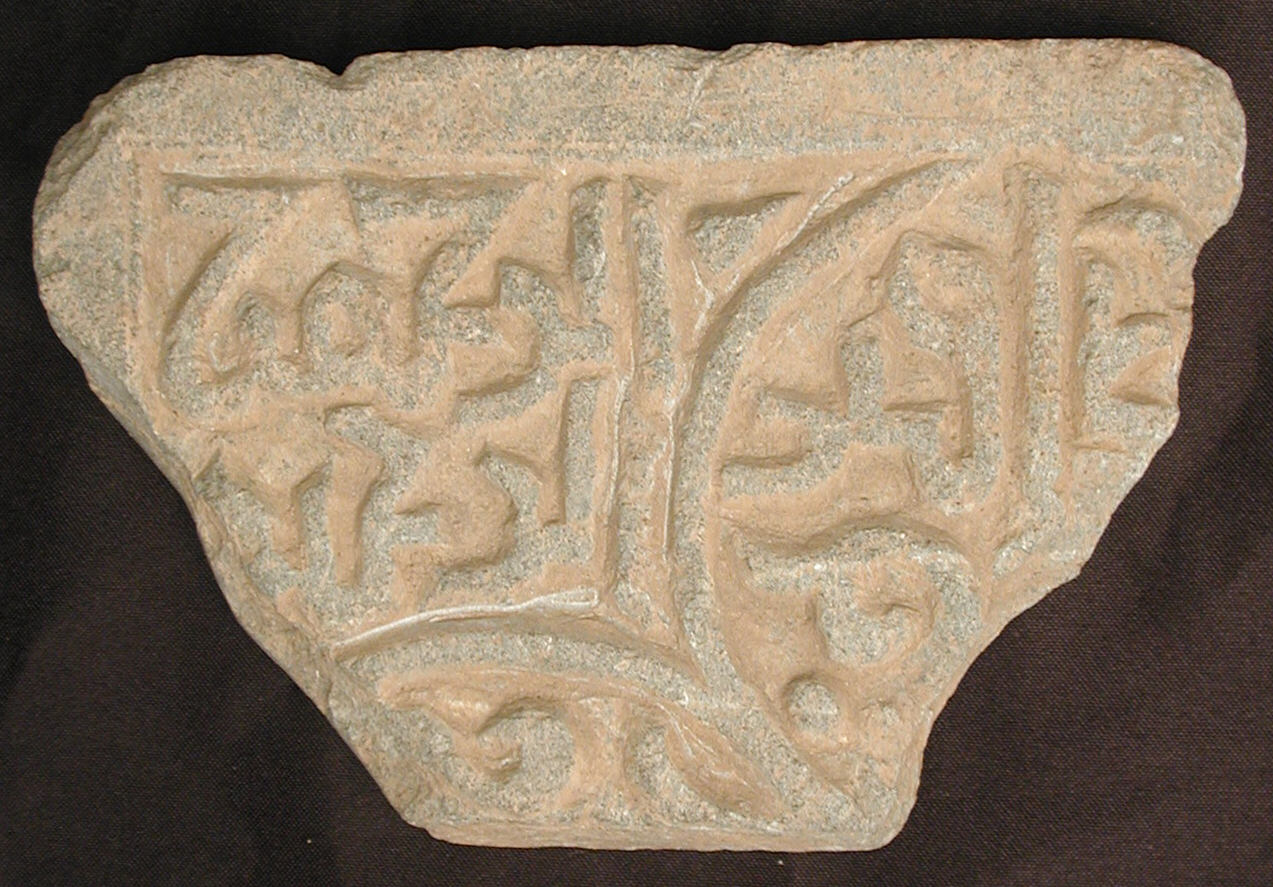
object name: tombstone fragment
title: Fragment of Tombstone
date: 701-1300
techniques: carving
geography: iran